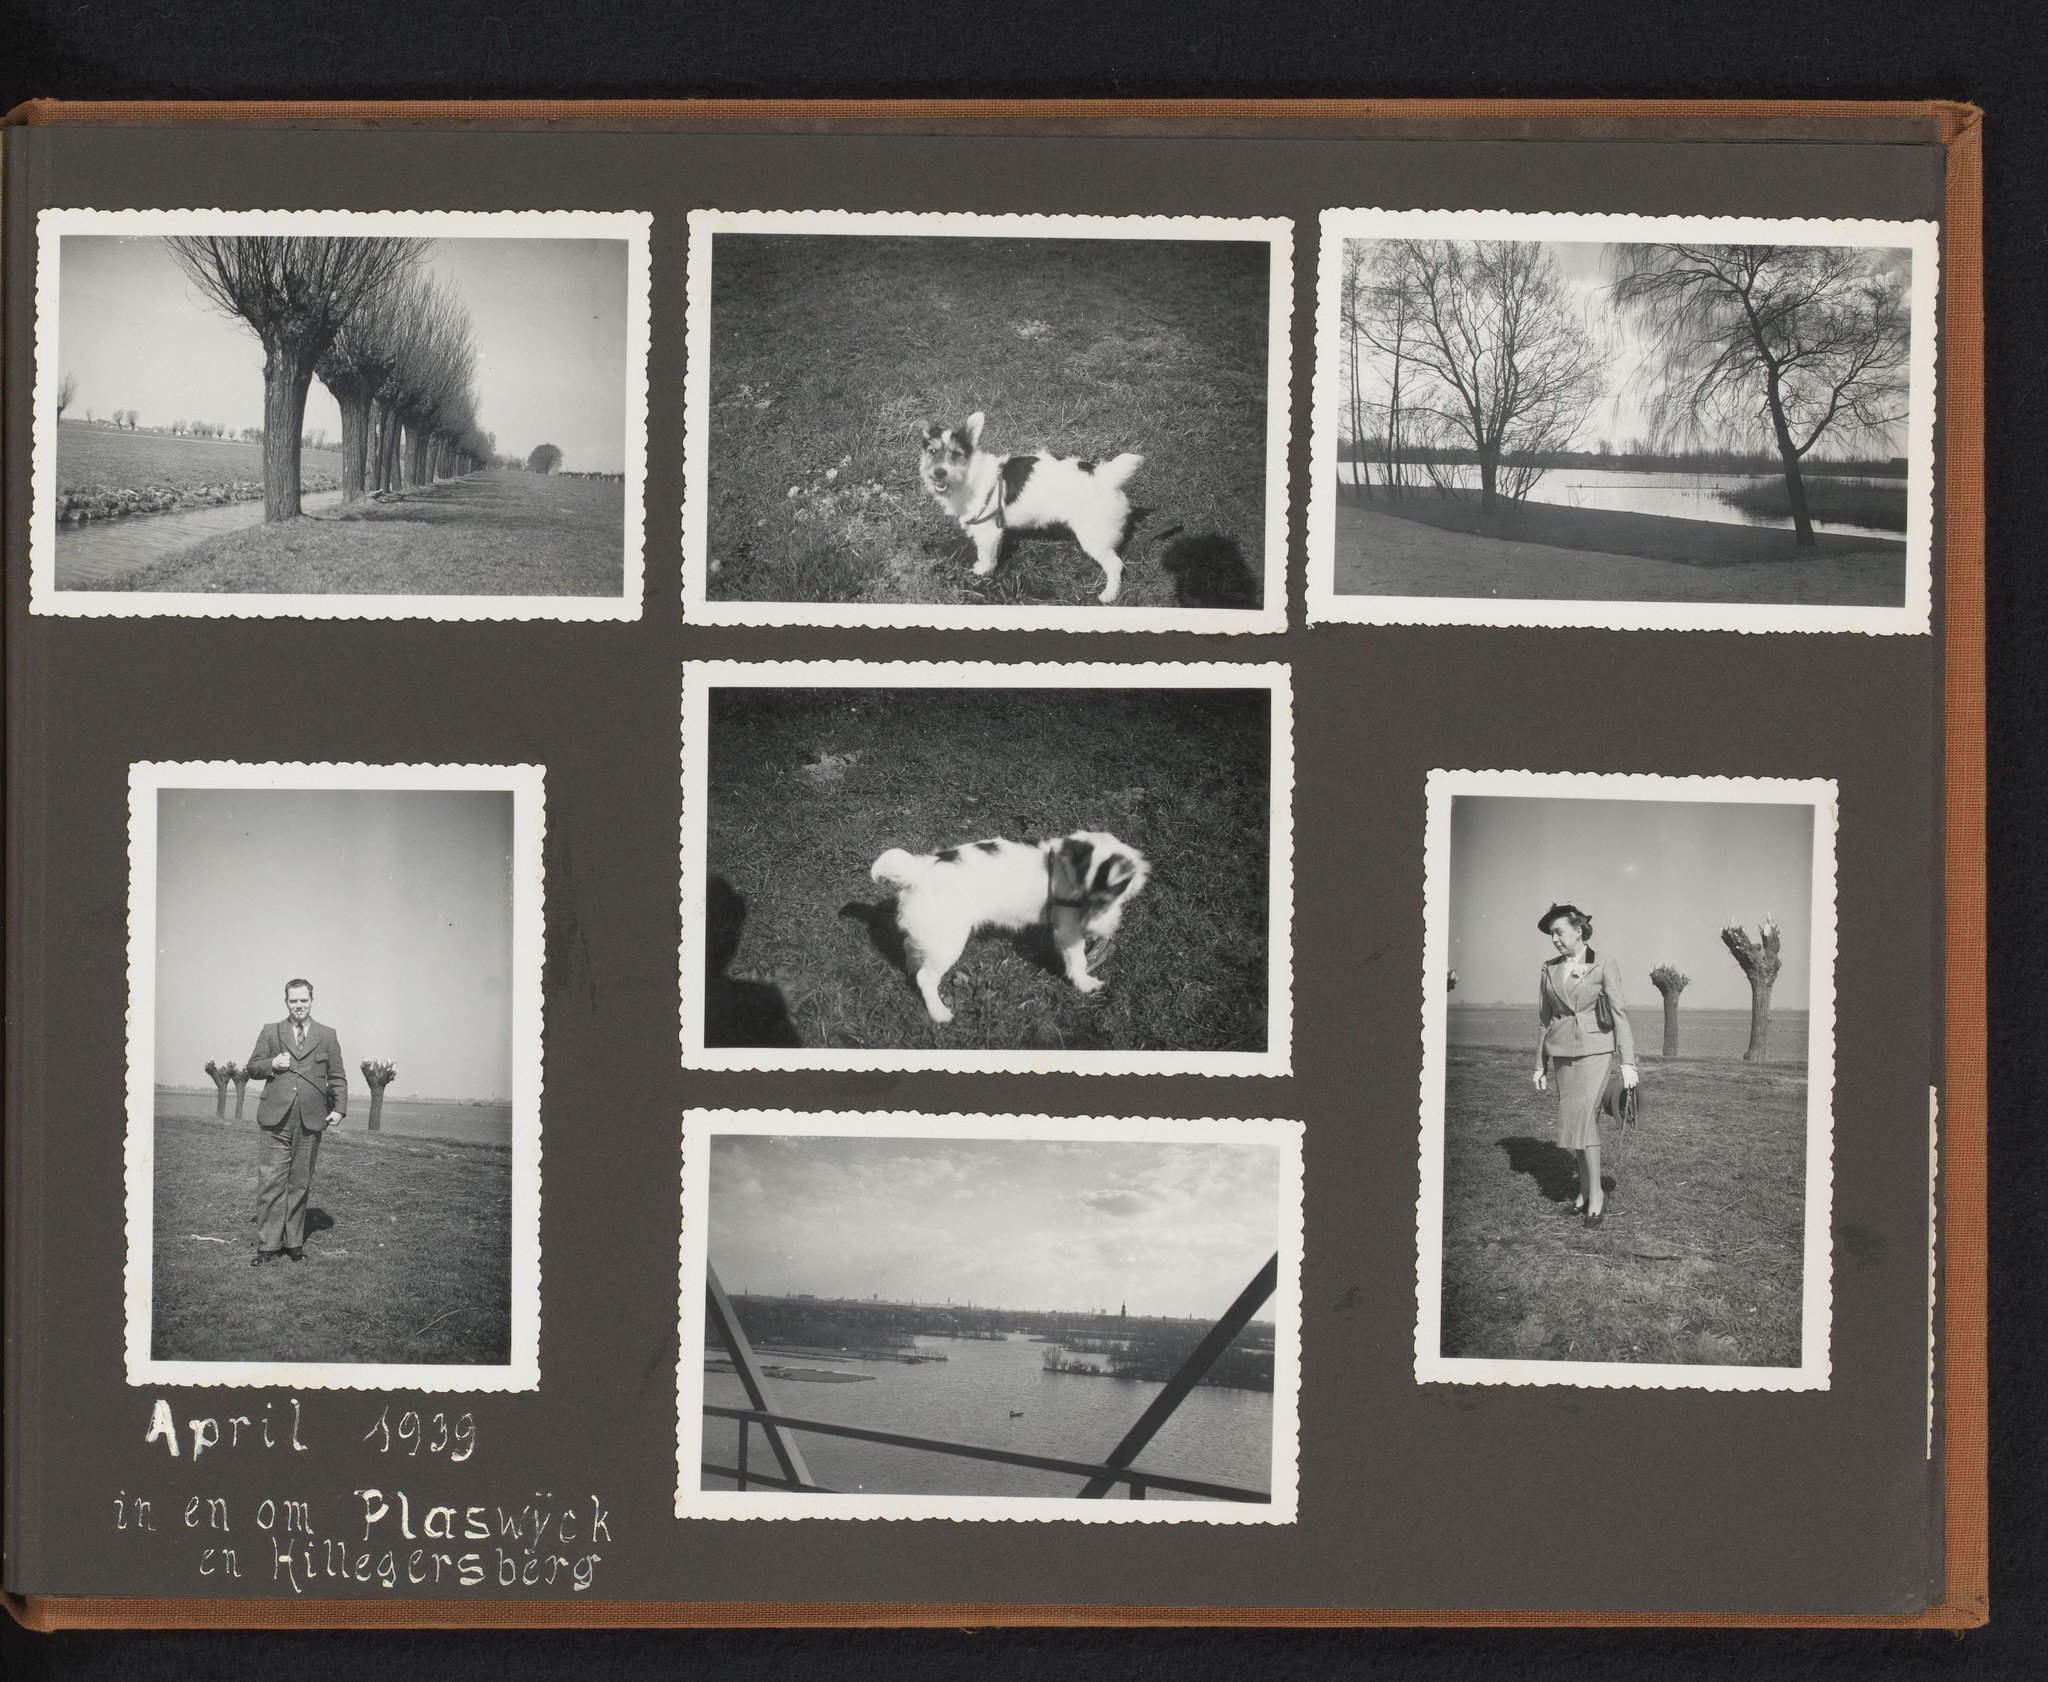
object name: album leaf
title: Berti Hoppe, Herman Besselaar en Bessie tijdens een dag uit in Plaswijck en Hillegersberg te Rotterdam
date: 1904-1939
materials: cardboard, paper, photographic support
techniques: gelatin silver print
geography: rotterdam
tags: herman besselaar, berti hoppe, walking the dog, landscapes in the temperate zone (+ landscape with figures, staffage), rotterdam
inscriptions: date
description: Drie landschappen, twee foto's van hond Bessie en twee portretten van Herman Besselaar en Berti Hoppe. Deze pagina maakt deel uit van een album.